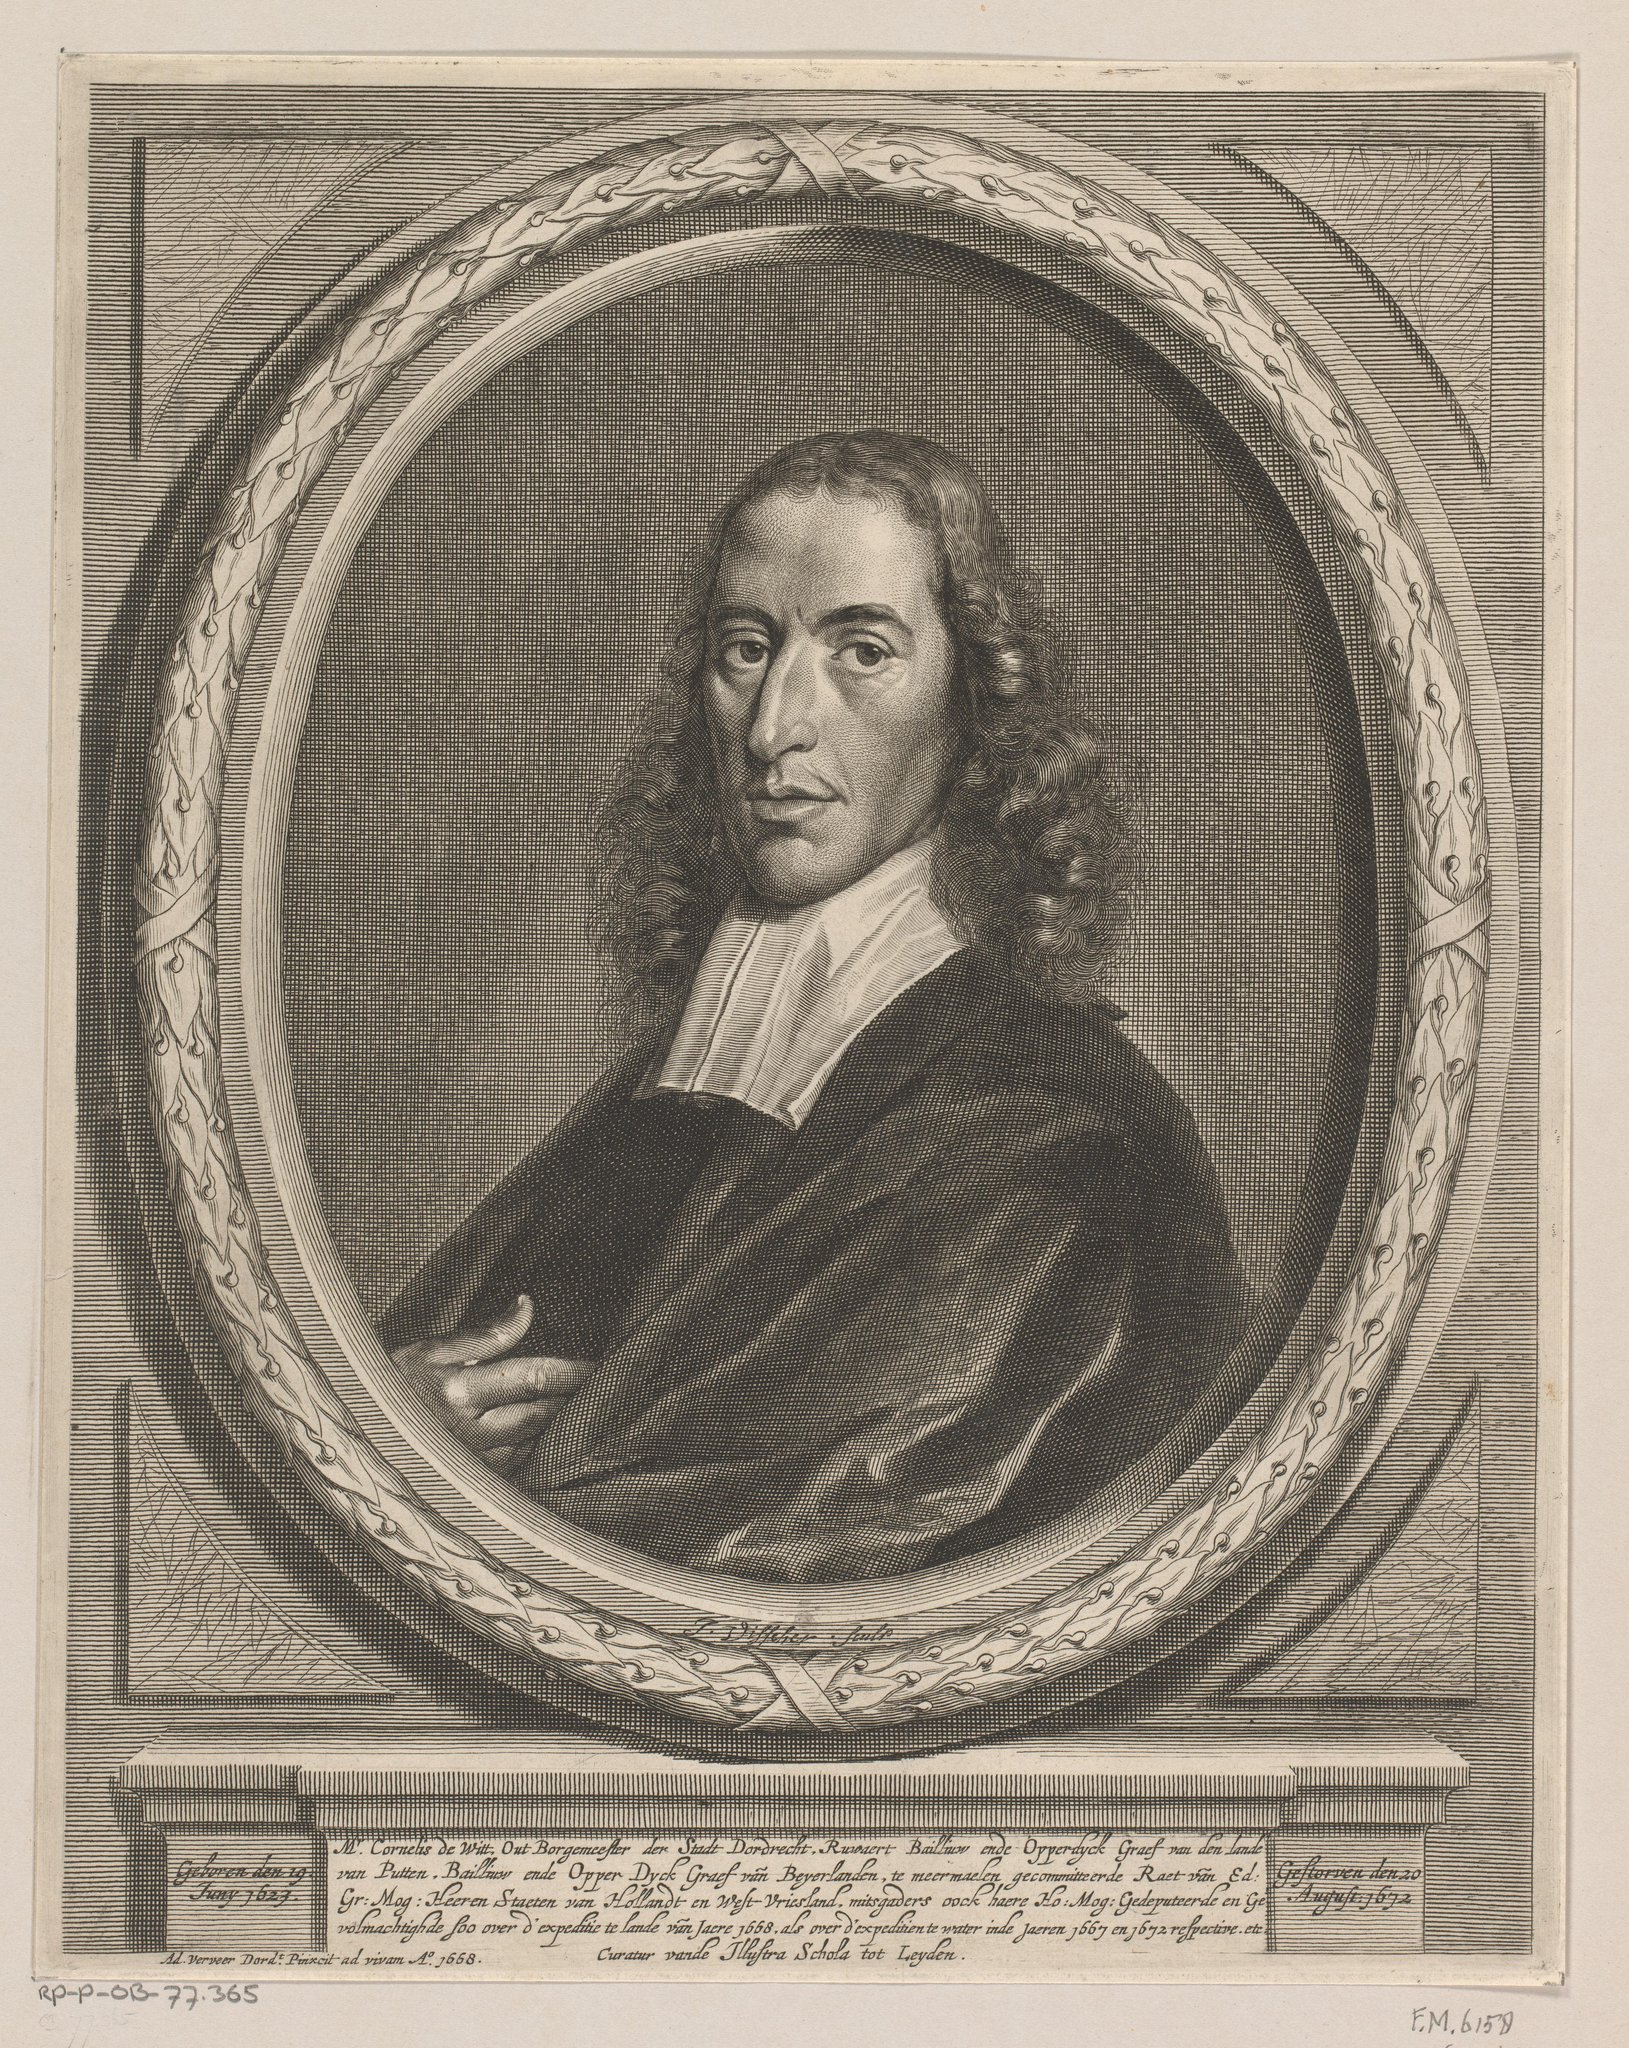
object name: print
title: Portret van Cornelis de Witt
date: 1672-1712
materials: paper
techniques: engraving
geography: netherlands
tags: dordrecht, the hague, cornelis de witt, historical persons, governor, etc. of province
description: Portret van Cornelis de Witt, in een ovaal. Onder het portret een Nederlands onderschrift.